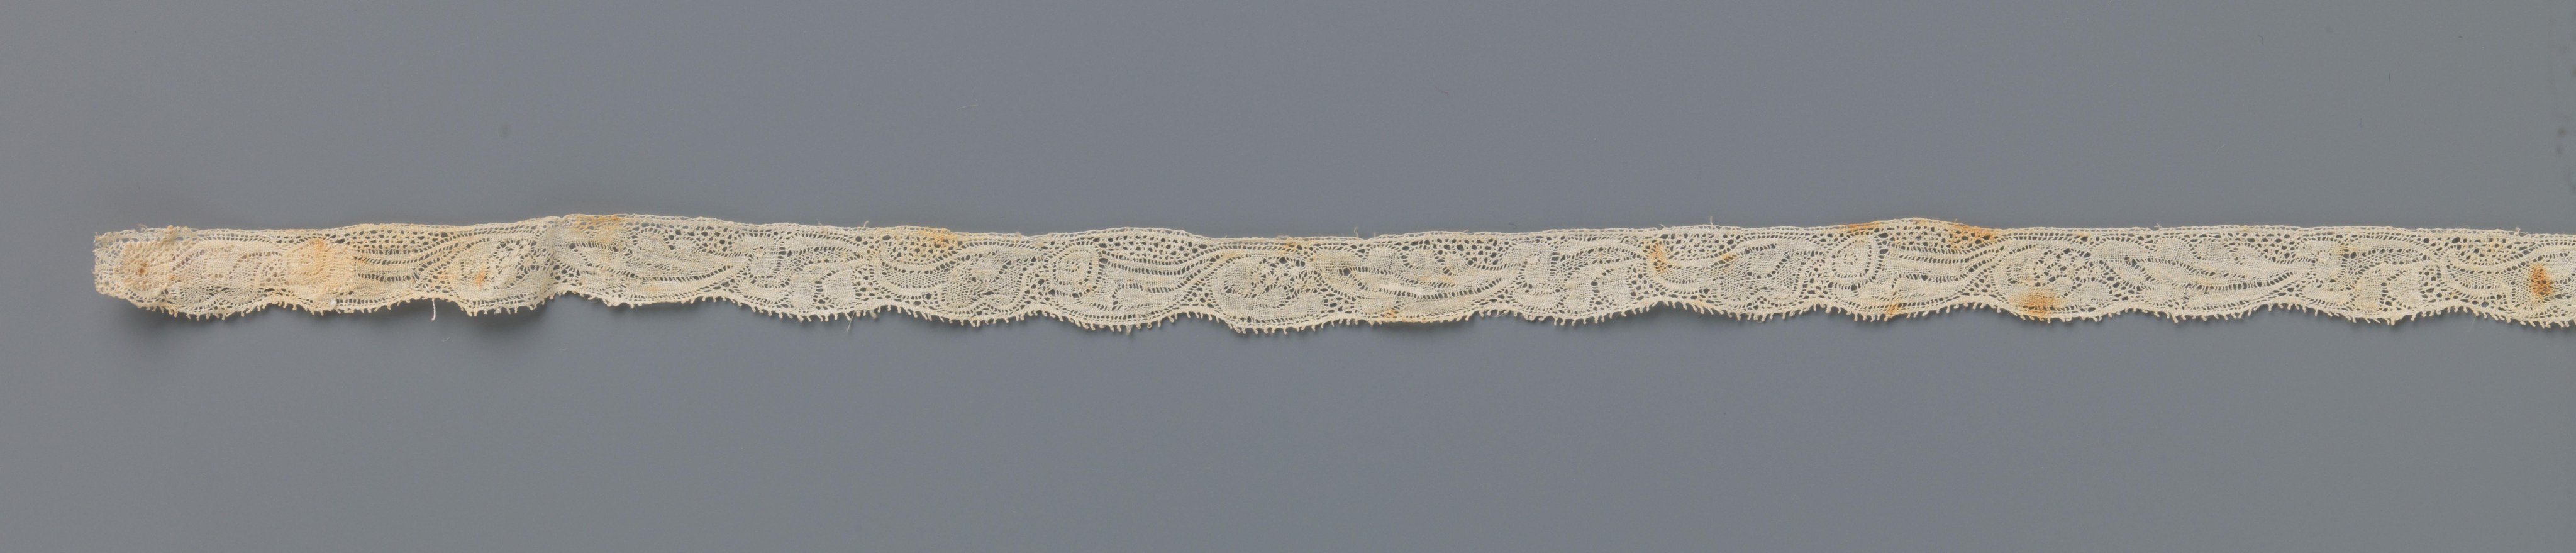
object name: strip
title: Strook kloskant met aaneenschakeling van vijf verschillende bladeren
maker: Anonymous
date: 1700-1799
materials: linen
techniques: lace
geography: flanders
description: Strook naturelkleurige kloskant, oudvlaamse kant. Het zich herhalende patroon bestaat uit een aaneenschakeling van vijf verschillende bladeren. Eén blad wordt door een ovaaltje oversneden. De motieven zijn met elkaar verbonden door een traliegrond, een vijfgaatjesgrond. De motieven zijn gemaakt in linnenslag met opengewerkte randjes, twee van de blaadjes hebben een netslagvulling. Eén van de vijf bladeren is teruggebogen, waaronder een siergrond is toegepast, een sneeuwvlokkengrond. De bovenzijde is recht afgewerkt. De flauw geschulpte onderzijde komt voort uit het patroon en is afgewerkt met picots.